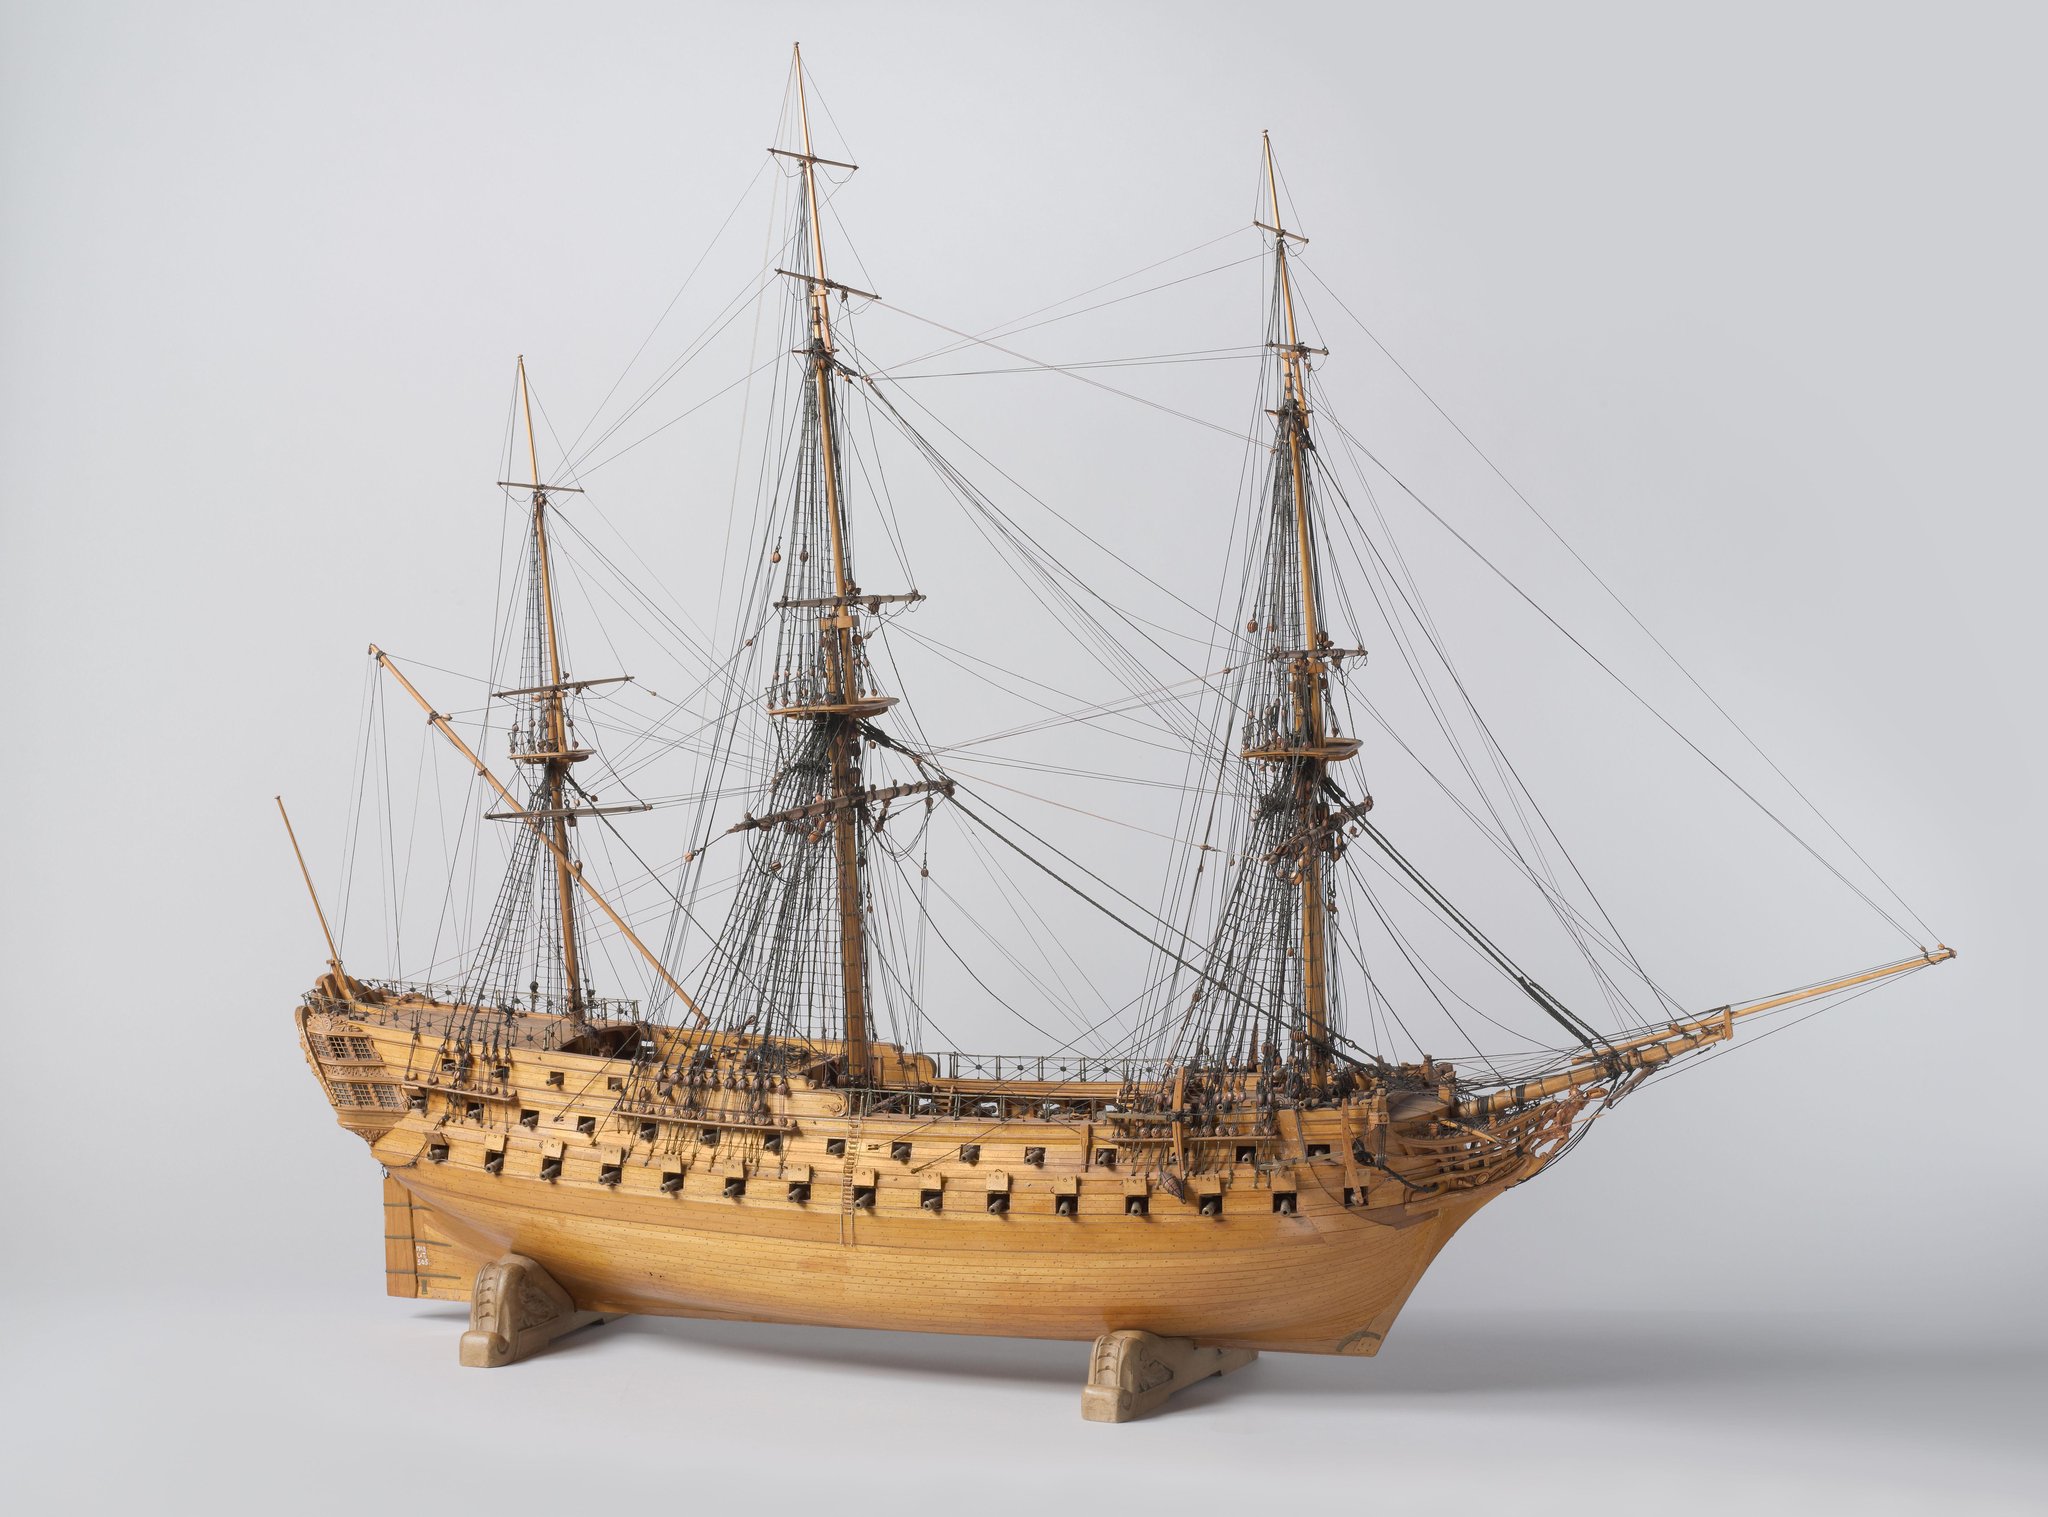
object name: fully rigged model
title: Model of a 90-Gun Ship of the Line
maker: Anonymous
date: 1801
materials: brass, fiber, wood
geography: netherlands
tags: chattam (schip)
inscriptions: inscription, on the stern: ‘ANº CHATTAM 1801’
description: Het linieschip van 90 stukken Chattam, lang 195 voet, werd in 1799-1800 door P. Glavimans Jz. te Rotterdam gebouwd. In 1809 werd het omgebouwd tot drijvende batterij en gebruikt bij de verdediging van Zeeland tegen de Engelse inval. In 1814 werd het als magazijnschip te Vlissingen door soldaten geplunderd; in 1823 voor de sloop verkocht.